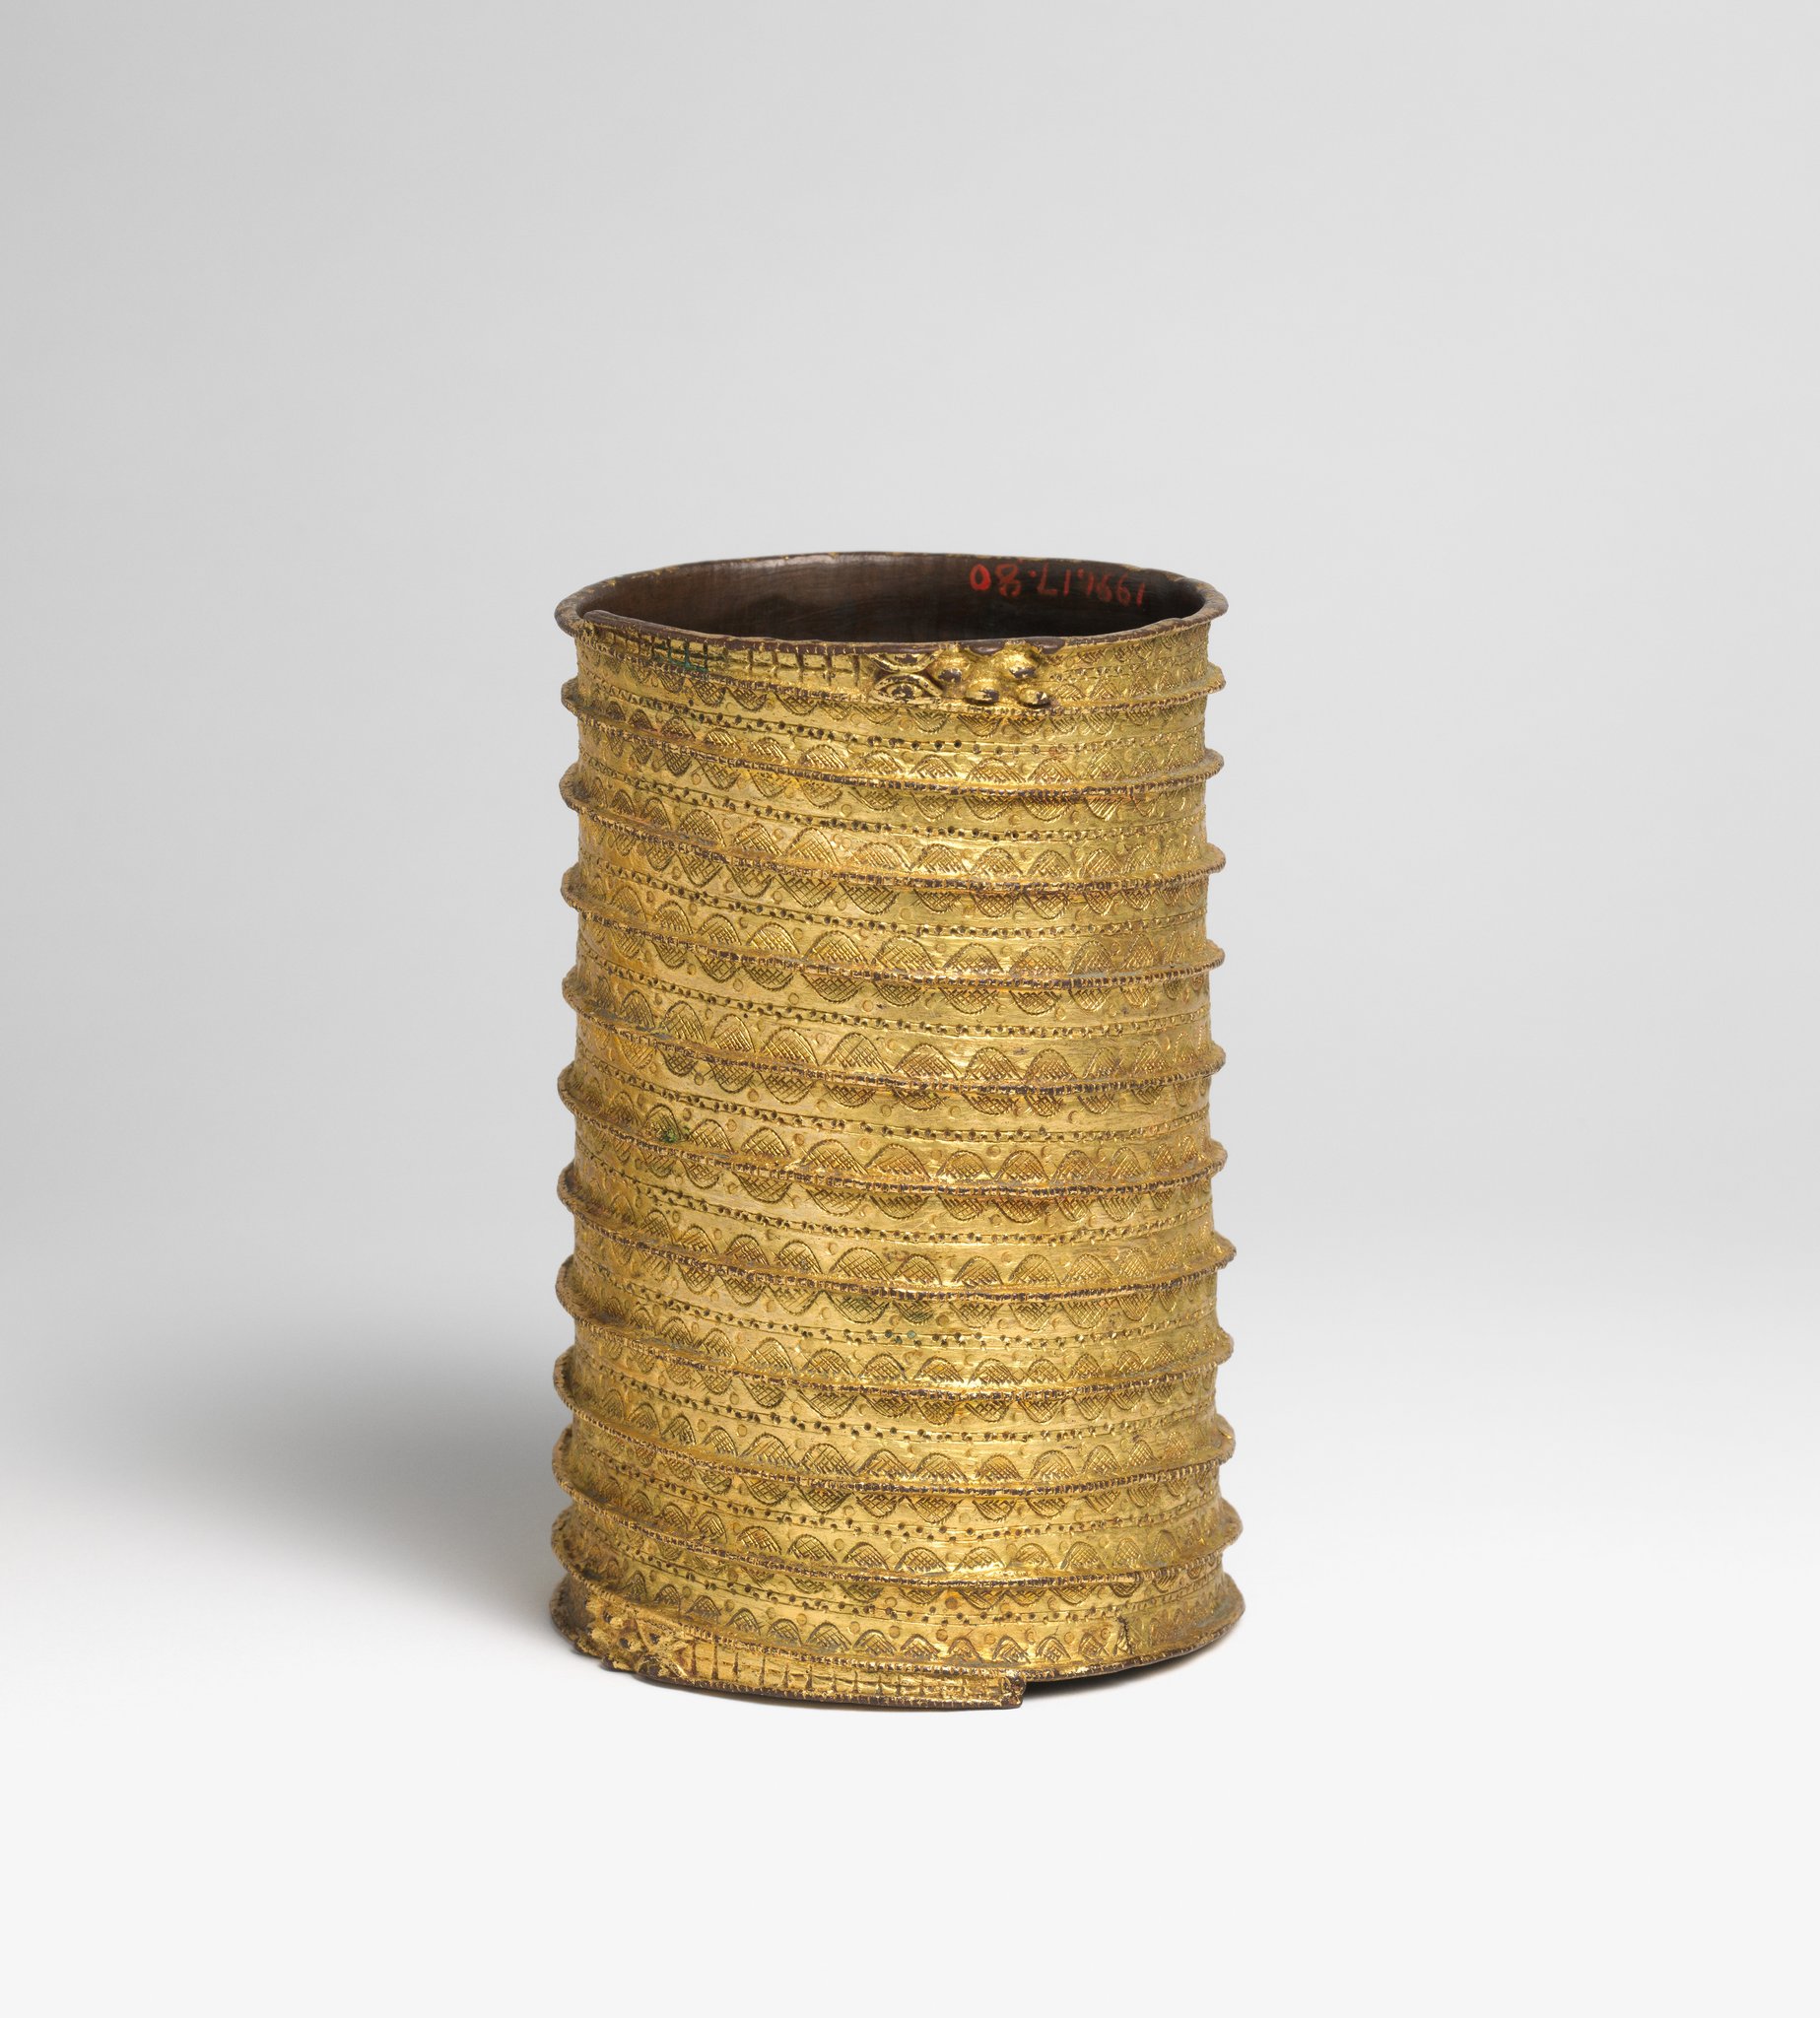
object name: bracelet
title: Bracelet: Crocodile Heads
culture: edo period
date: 1601-1900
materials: brass, gilt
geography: nigeria